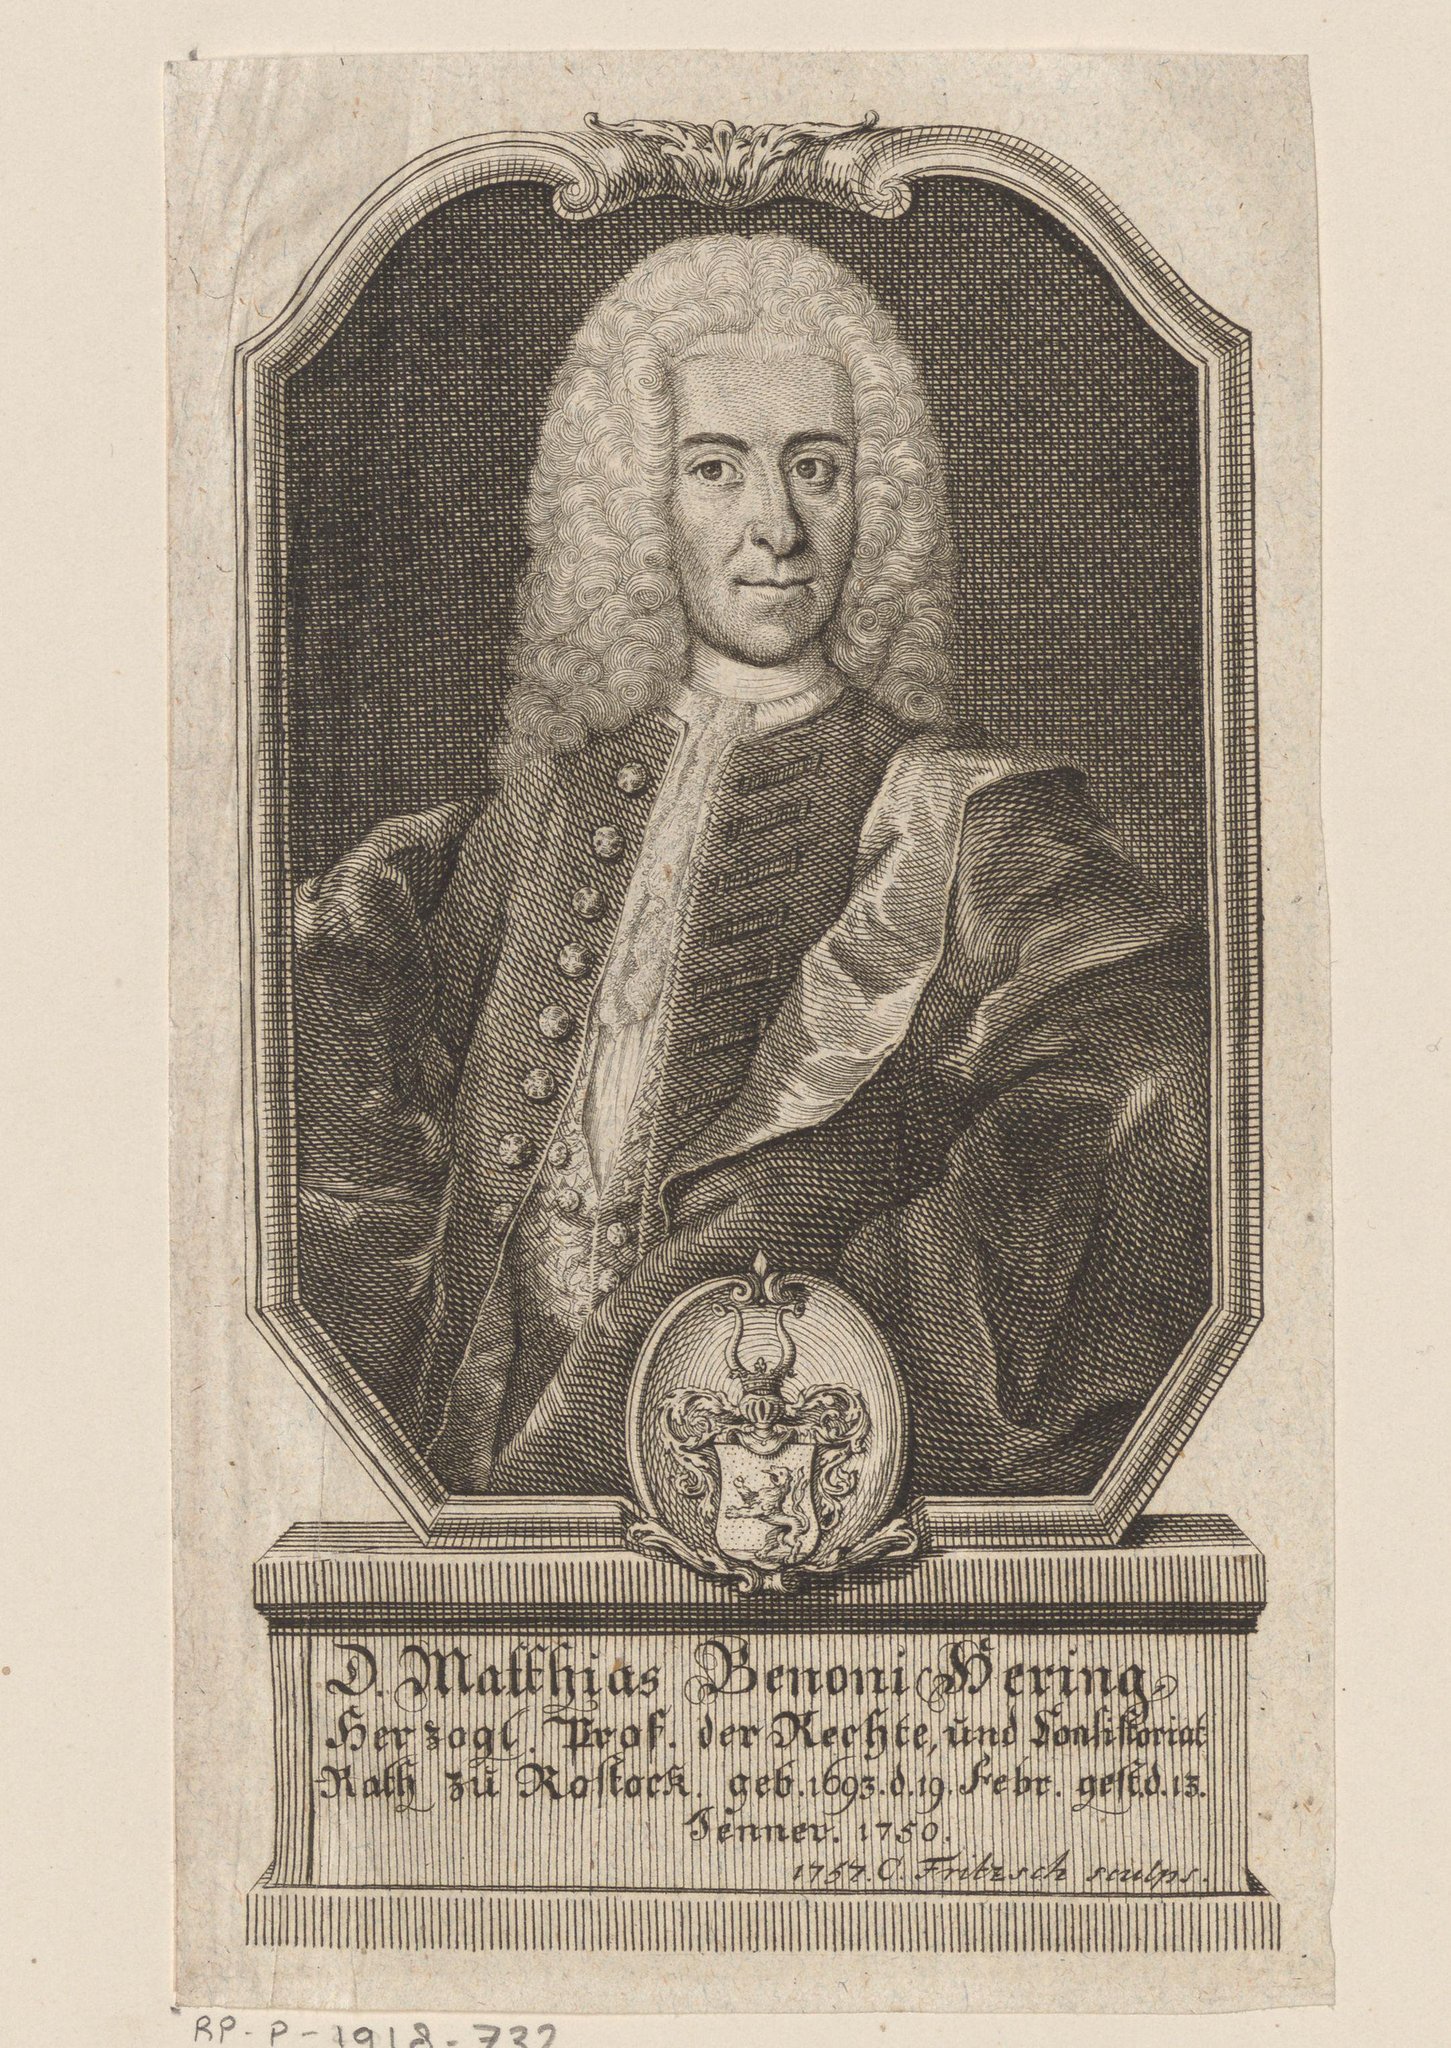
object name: print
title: Portret van Matthias Benoni Hering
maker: christian fritzsch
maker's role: print maker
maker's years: 1695-1769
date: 1750-1769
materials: paper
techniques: engraving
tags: historical persons, book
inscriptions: collector's mark: Lugt 2233